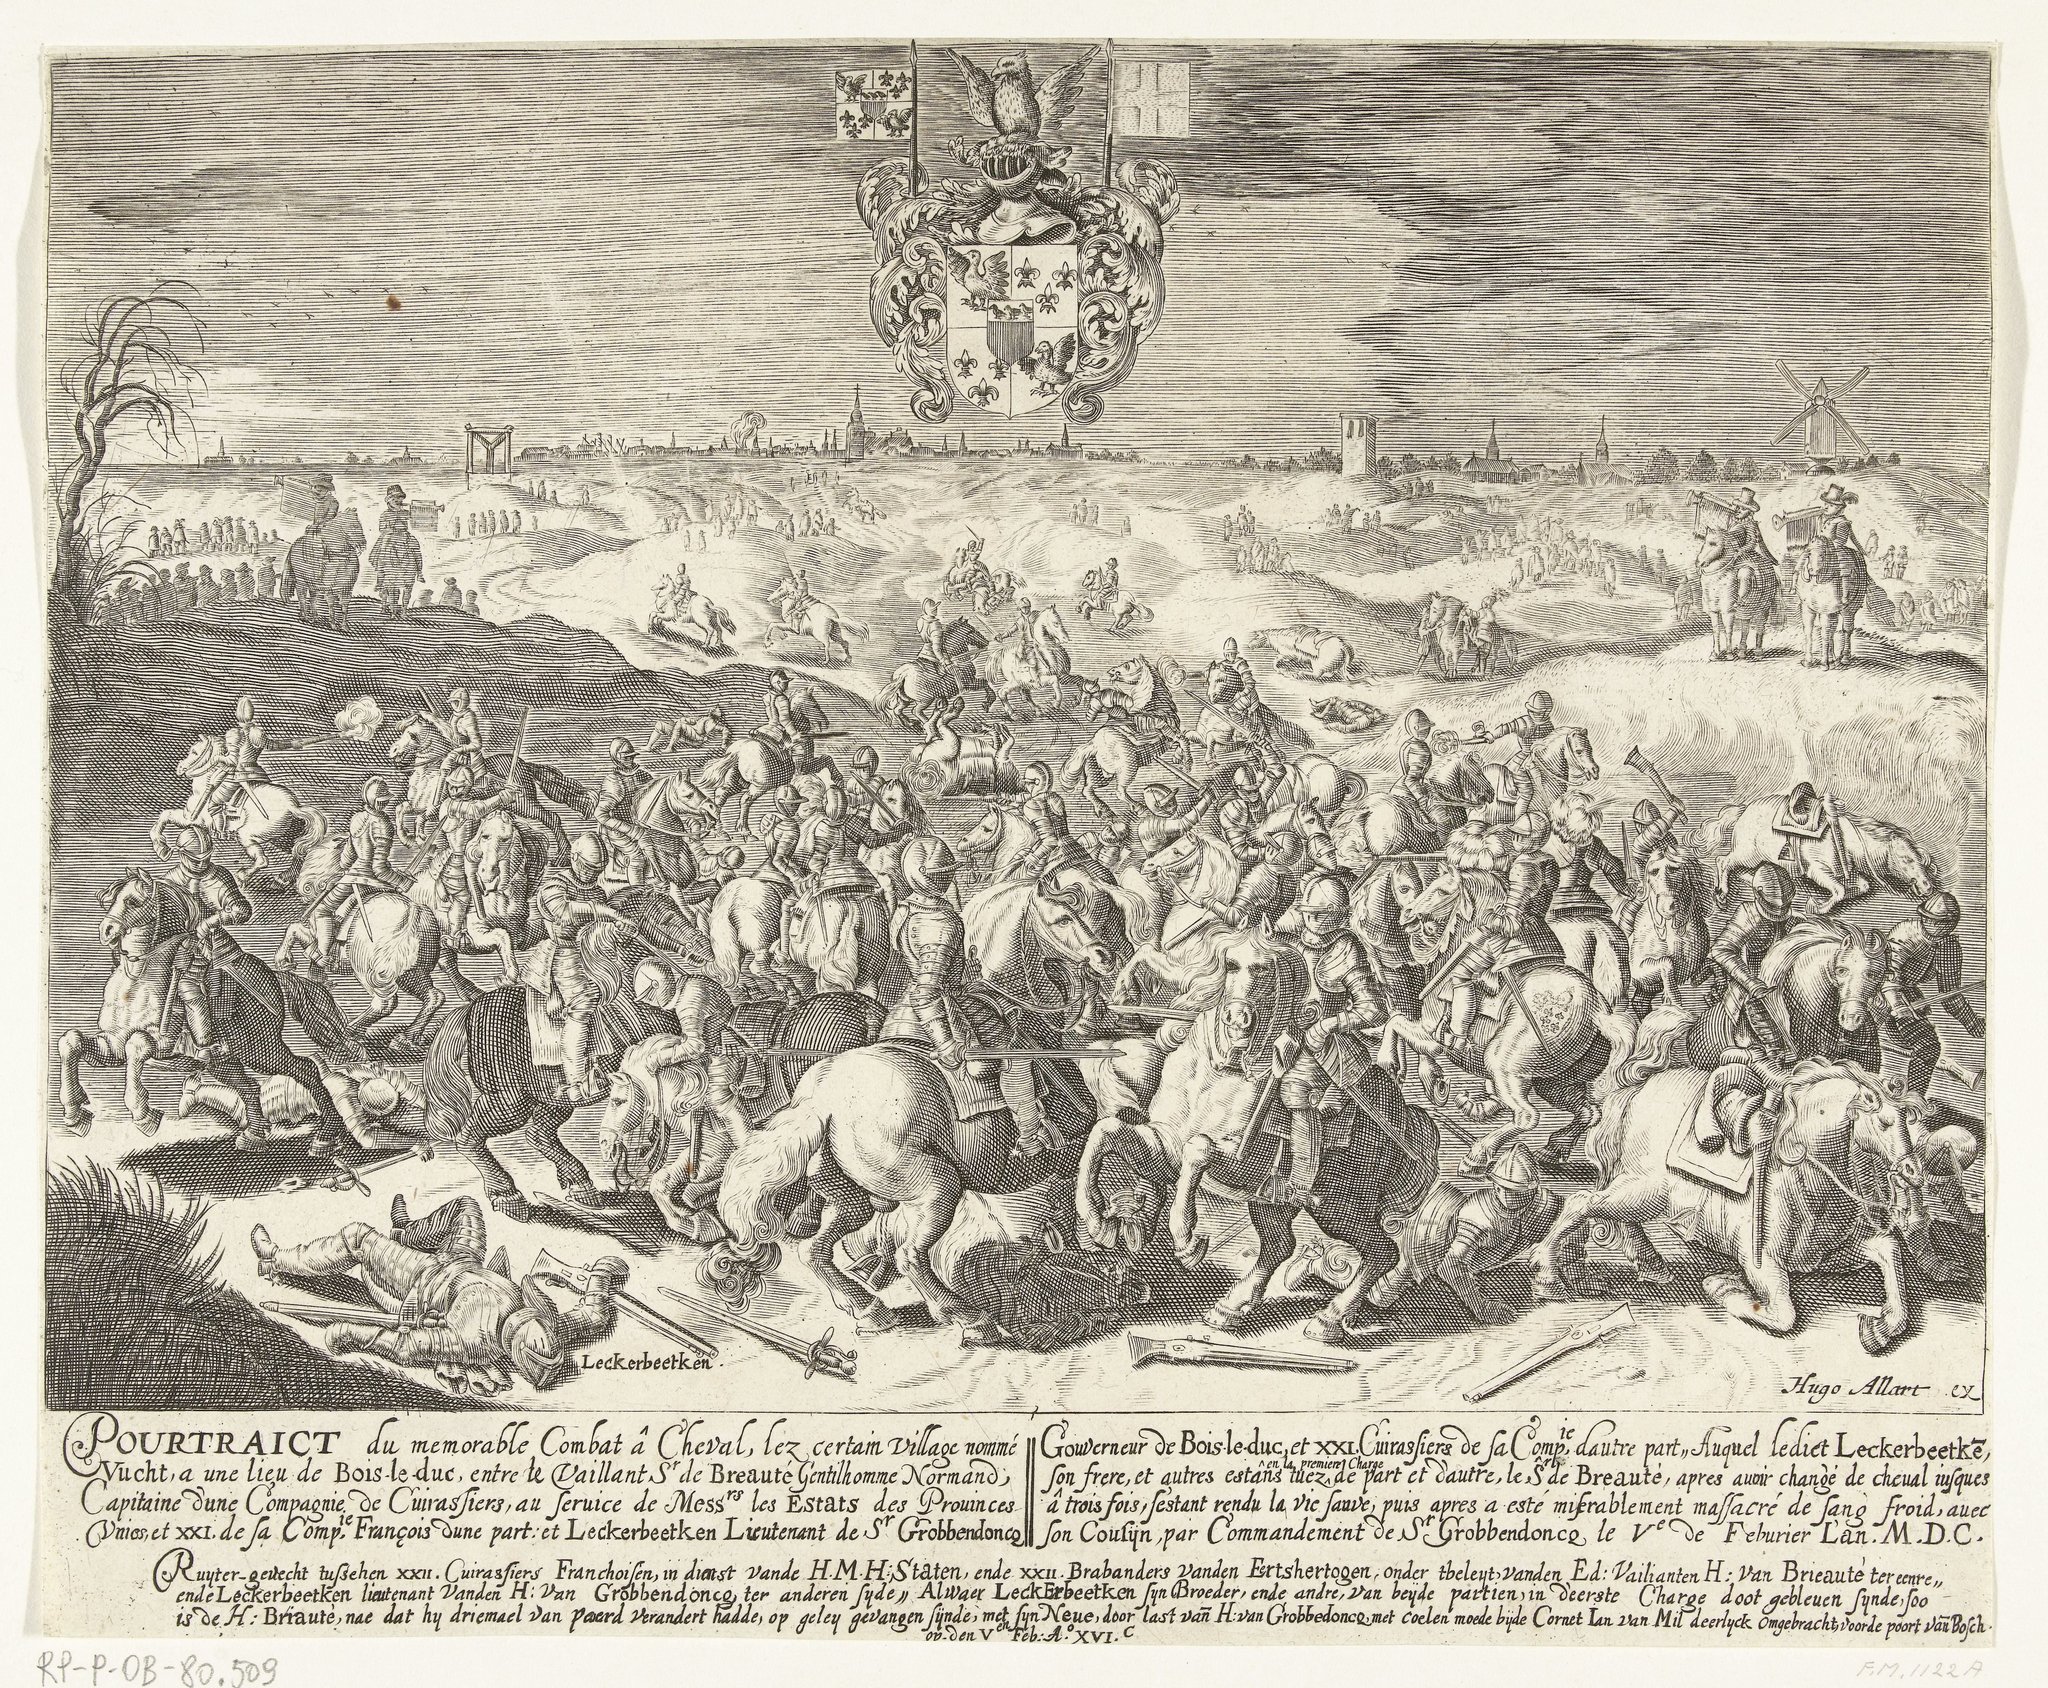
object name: history print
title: Pourtraict du memorable Combat a Cheval, lez certain Village nommé Vucht (...) entre de Vaillant Sr. de Breauté (...) au service de Messrs. les Estats des Provinces Unies, et XXI de sa Comp.ie François dune part: et Leckerbeetken Lieutenant de Sr. Grobbendoncq (...)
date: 1630-1680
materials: paper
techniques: engraving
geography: northern netherlands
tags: den bosch, battle (+ land forces)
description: Het gevecht van Lekkerbeetje. Ruitergevecht op de Vughterheide bij Den Bosch tussen de Spaanse ruiters onder Anthony Schetz van Grobbendonck en de Staatse ruiters onder de Pierre de Breauté, 5 februari 1600. Op de voorgrond links ligt de gesneuvelde Gerardt Abrahamsz. Lekkerbeetje. In de verte 's-Hertogenbosch en Vught. Bovenin het wapen van Grobbendonck. Met onderschrift in het Frans in 2 kolommen en daaronder 4 regels in het Nederlands.